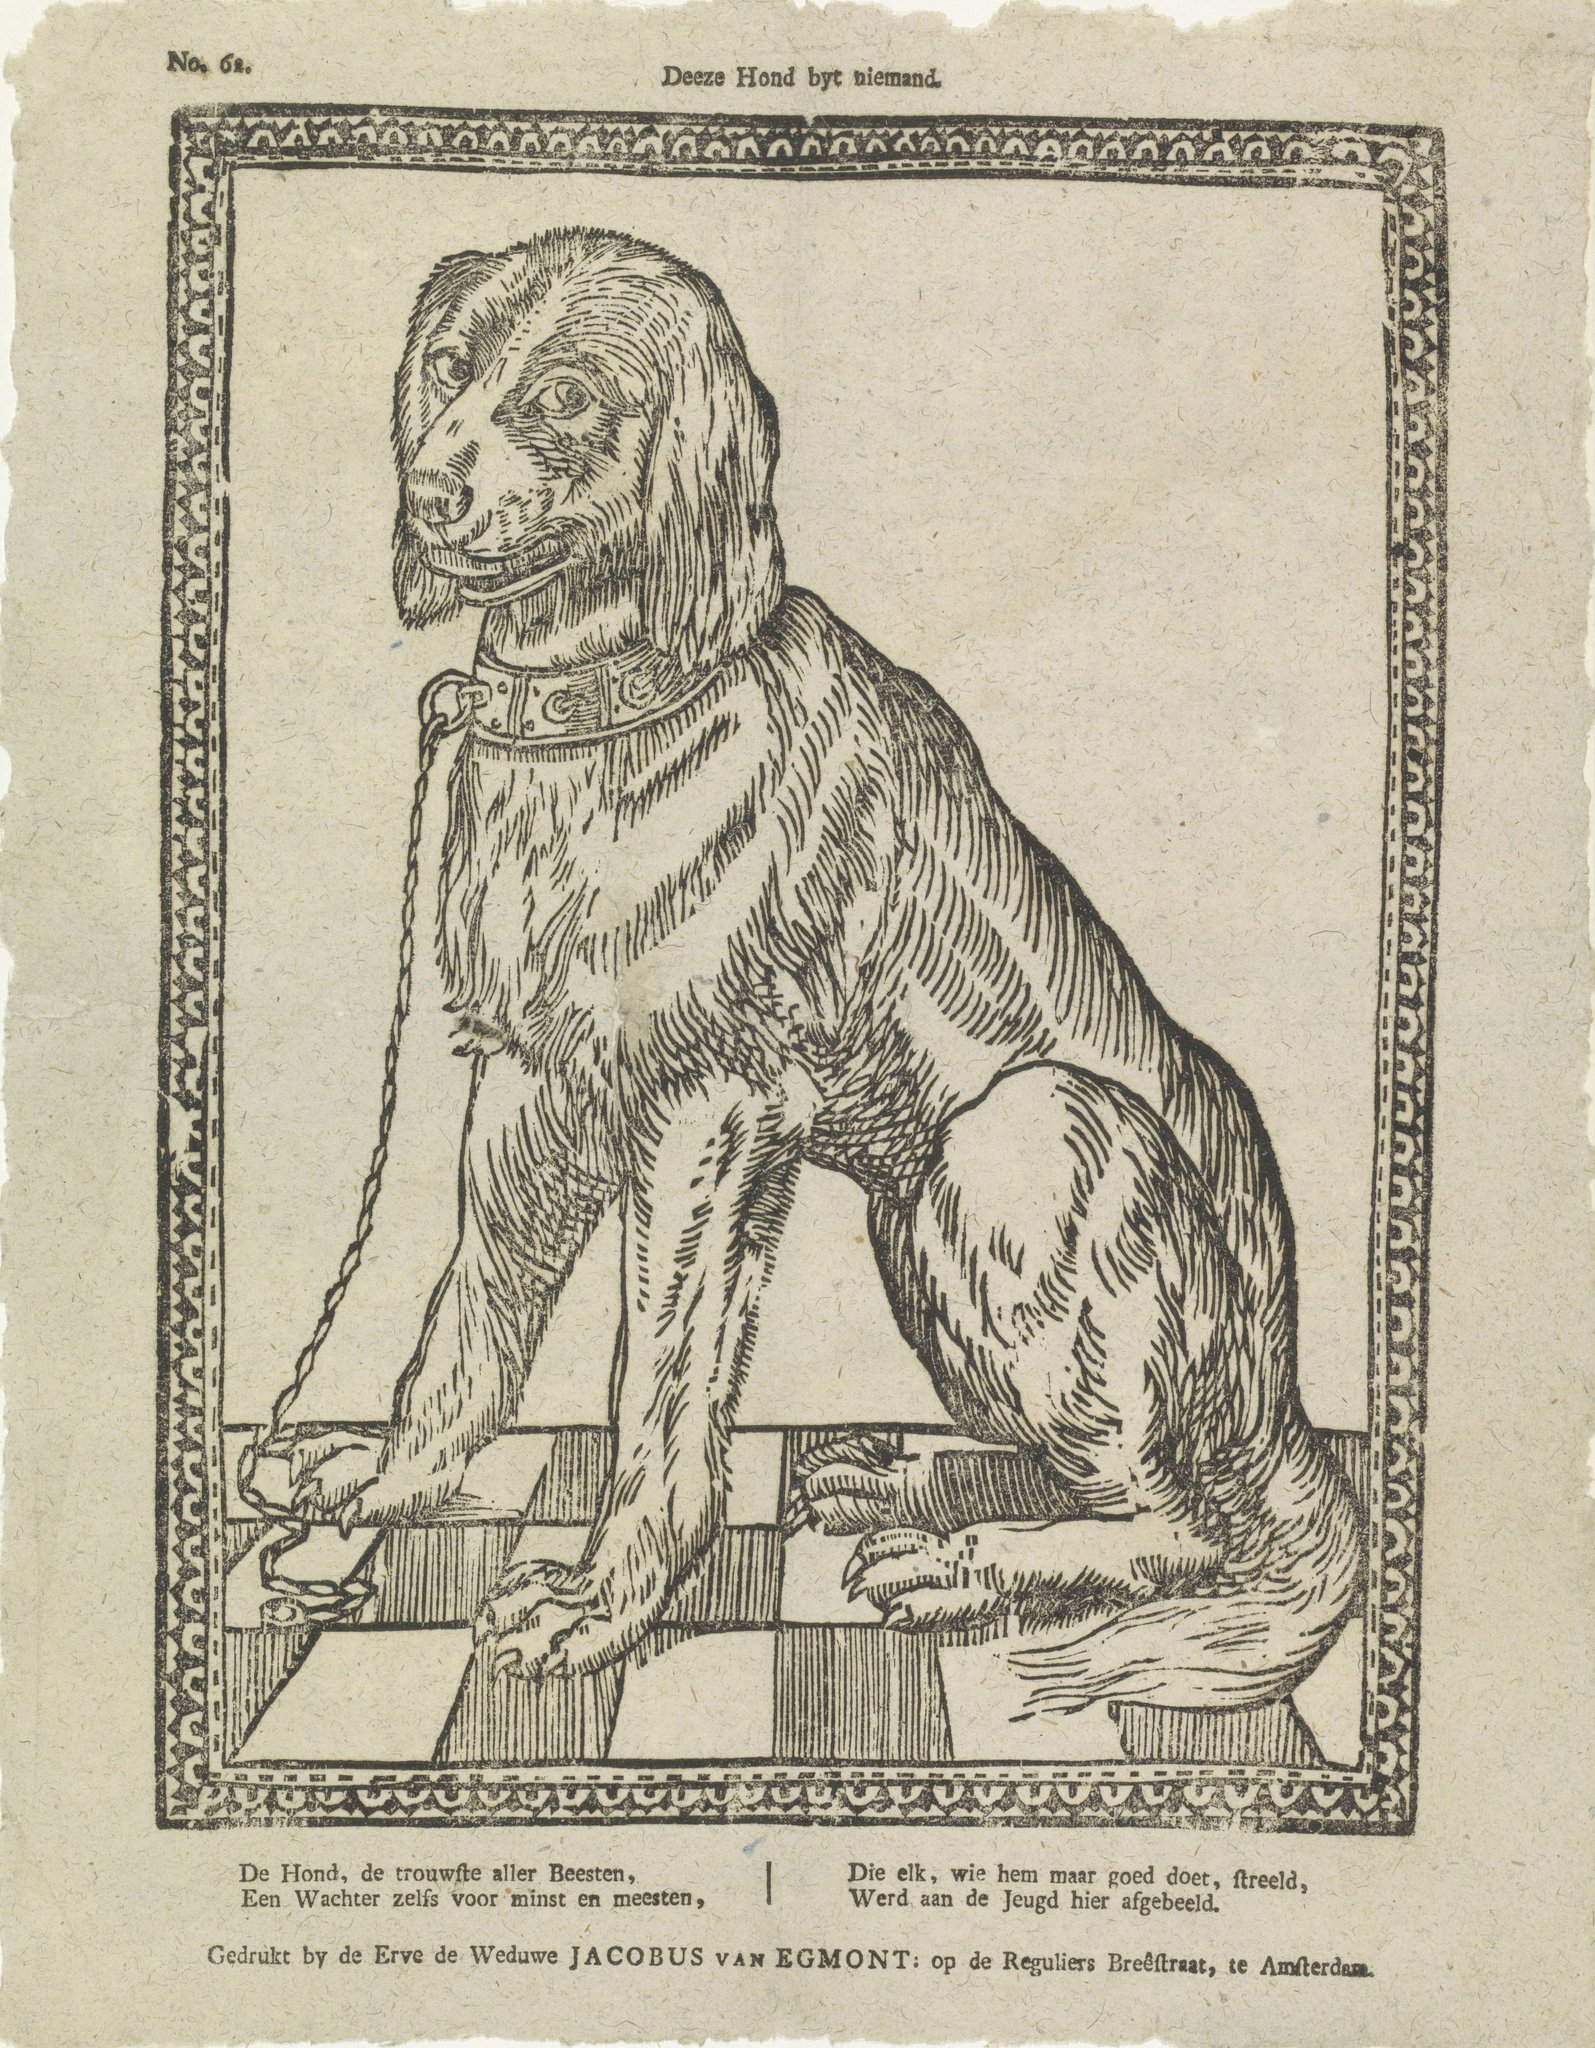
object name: popular print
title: Deeze Hond byt niemand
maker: Anonymous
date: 1761-1804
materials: paper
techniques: letterpress printing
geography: amsterdam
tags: dog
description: Een zittende hond met halsband. Geheel omgeven door een sierrand. Onder de voorstelling een vierregelig vers in twee kolommen. Genummerd linksboven: No. 62.